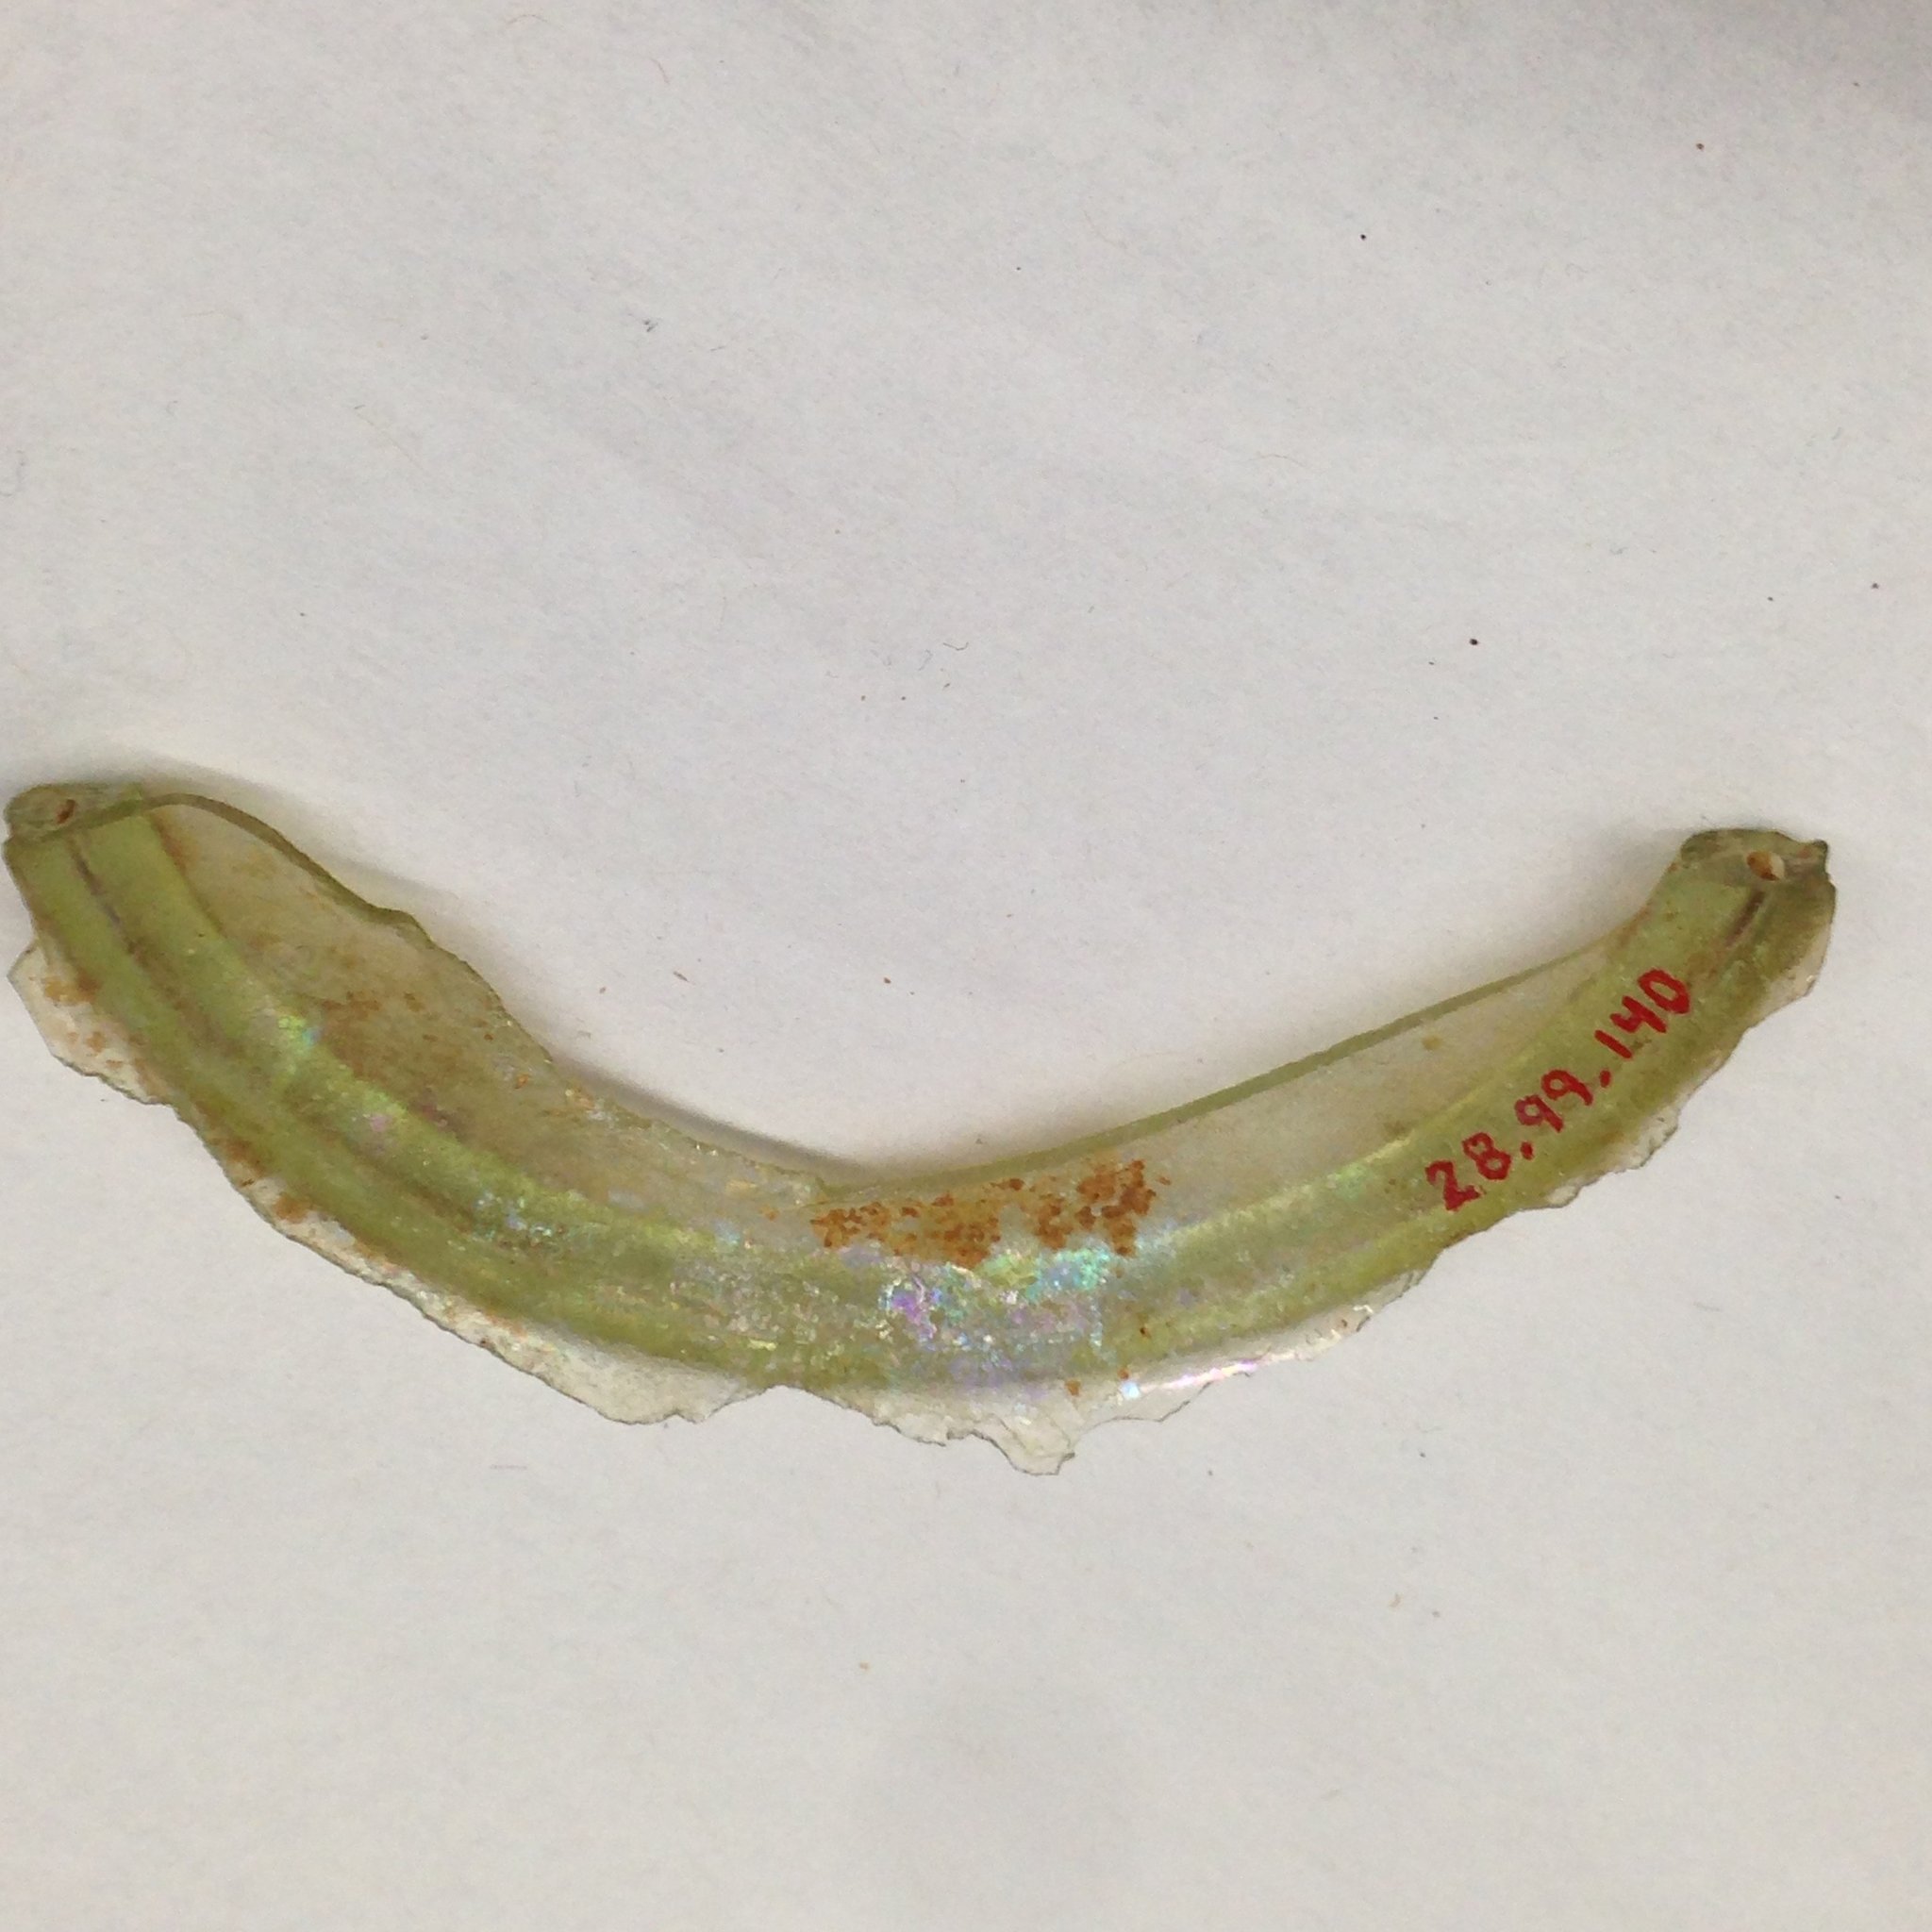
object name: fragment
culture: european or middle eastern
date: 1150-1250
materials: ceramic, glass